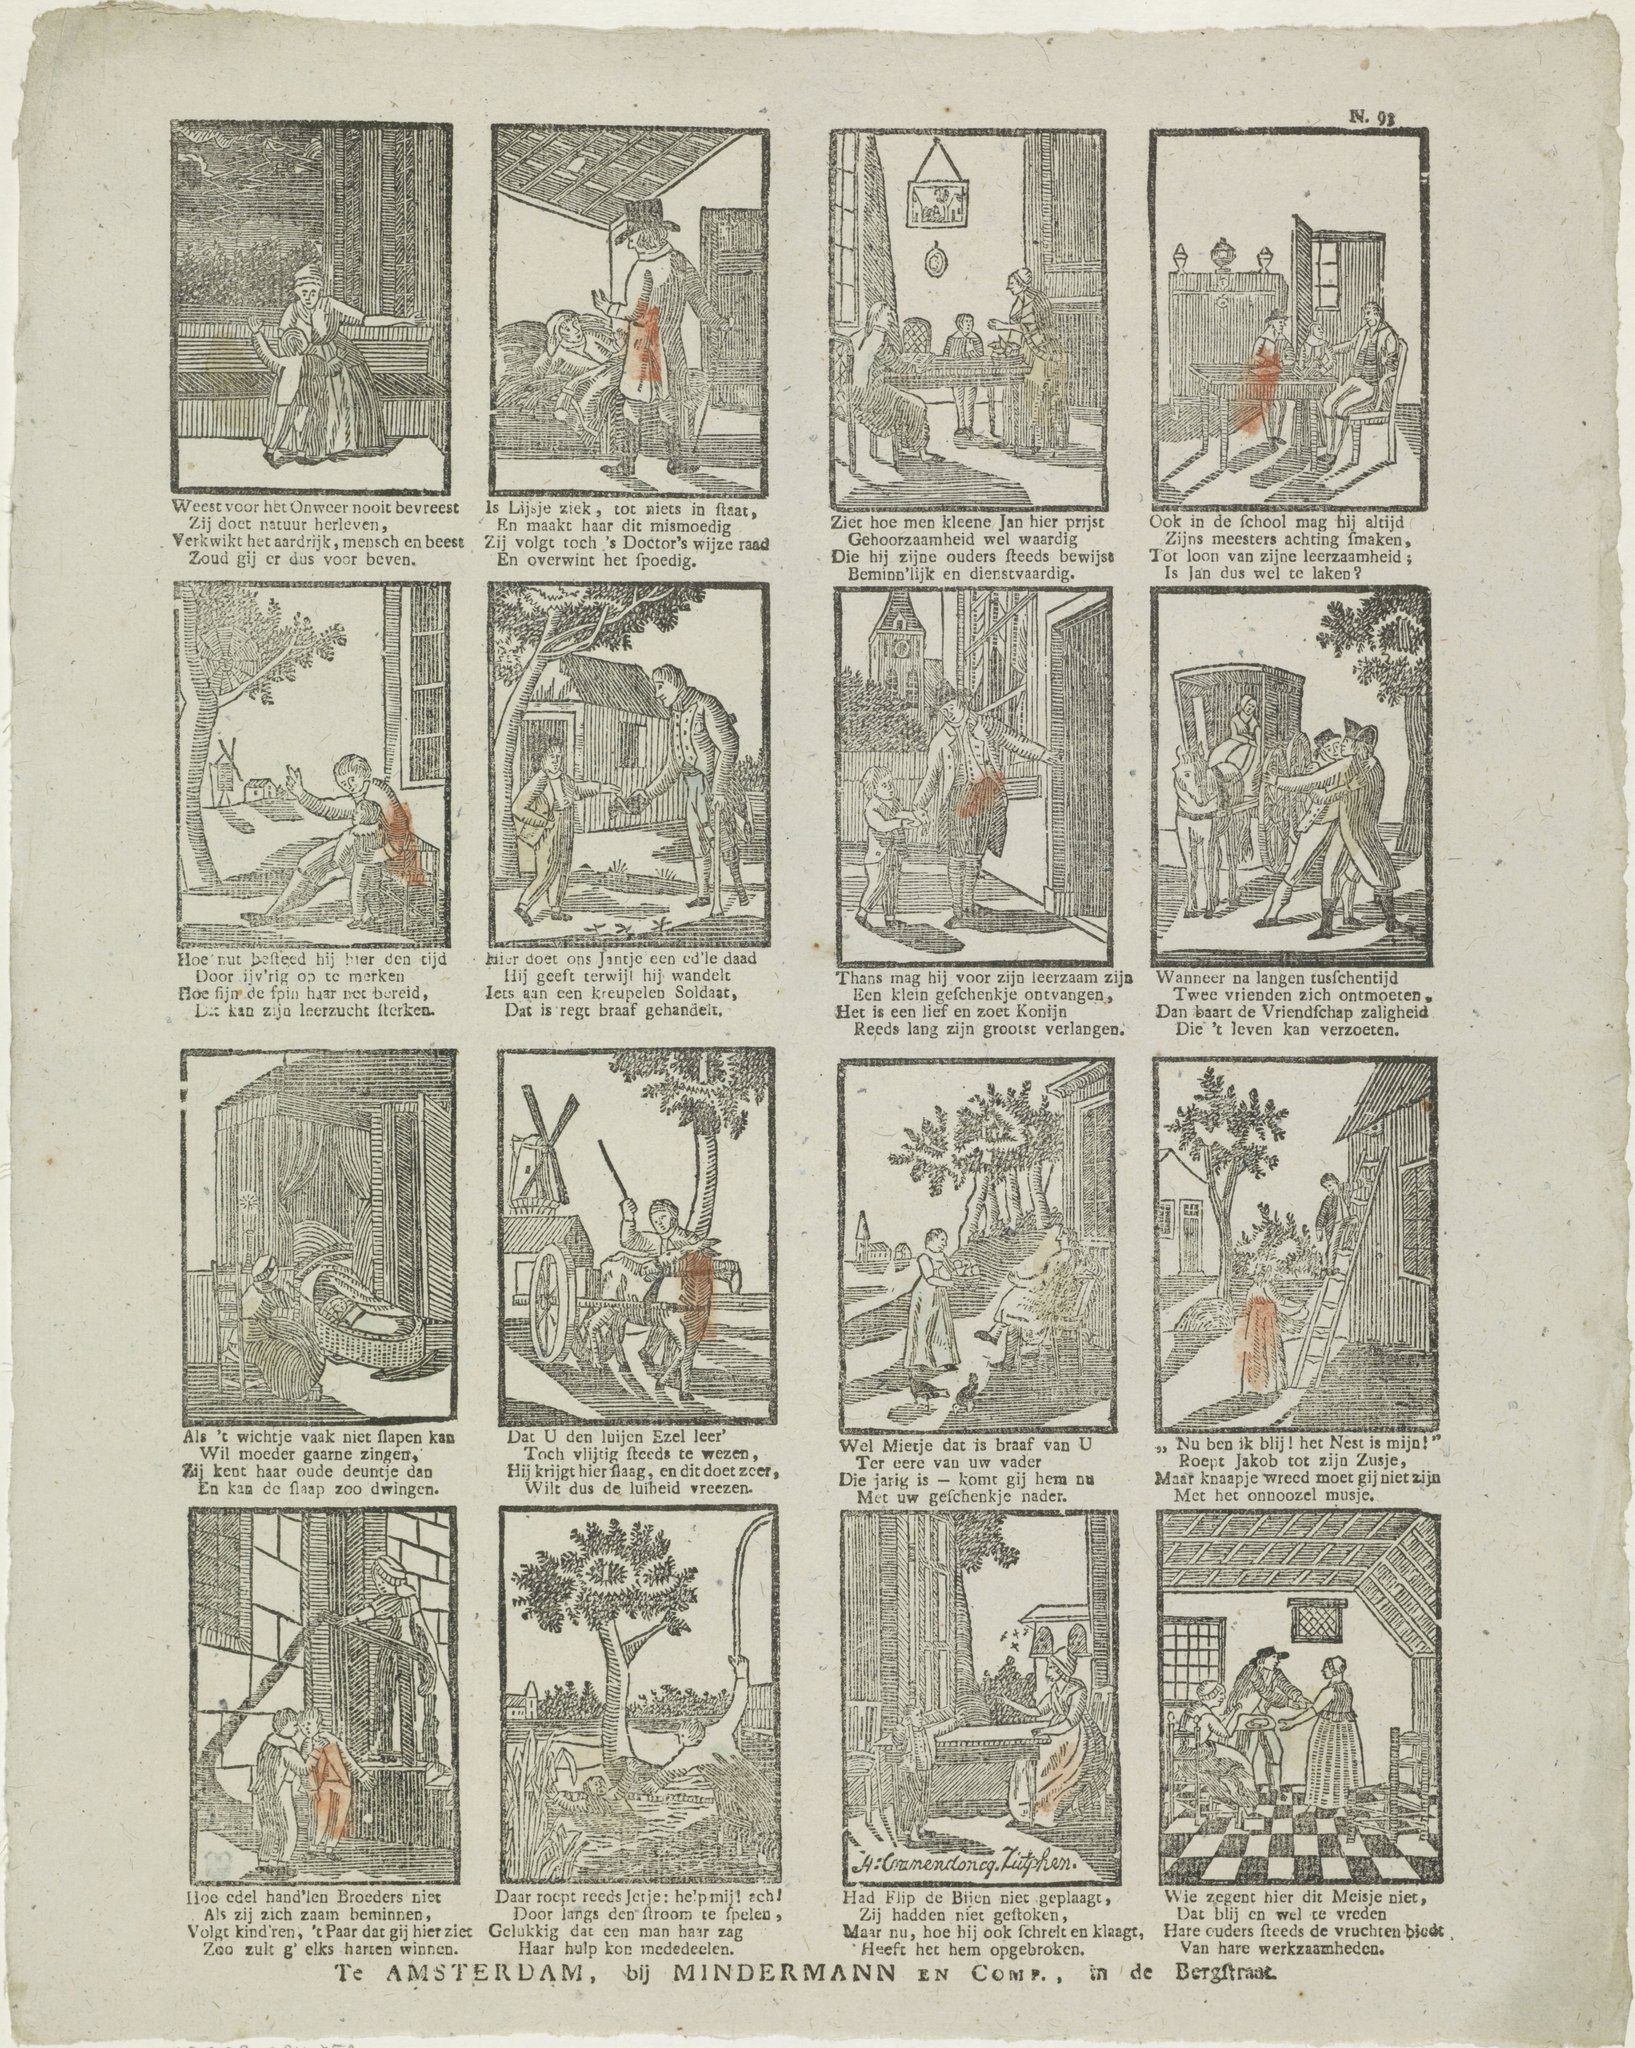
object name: print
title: Kinderleven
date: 1822-1849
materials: paper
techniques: colour, letterpress printing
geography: zutphen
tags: child, four-wheeled, animal-drawn vehicle, e.g.: cab, carriage, coach, physician, doctor, thunderstorm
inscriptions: collector's mark: Lugt 2760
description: Blad met 16 voorstellingen van verschillende aard, waaronder taferelen uit het kinderleven. Onder elke afbeelding een vierregelig vers. Genummerd rechtsboven: N. 93.